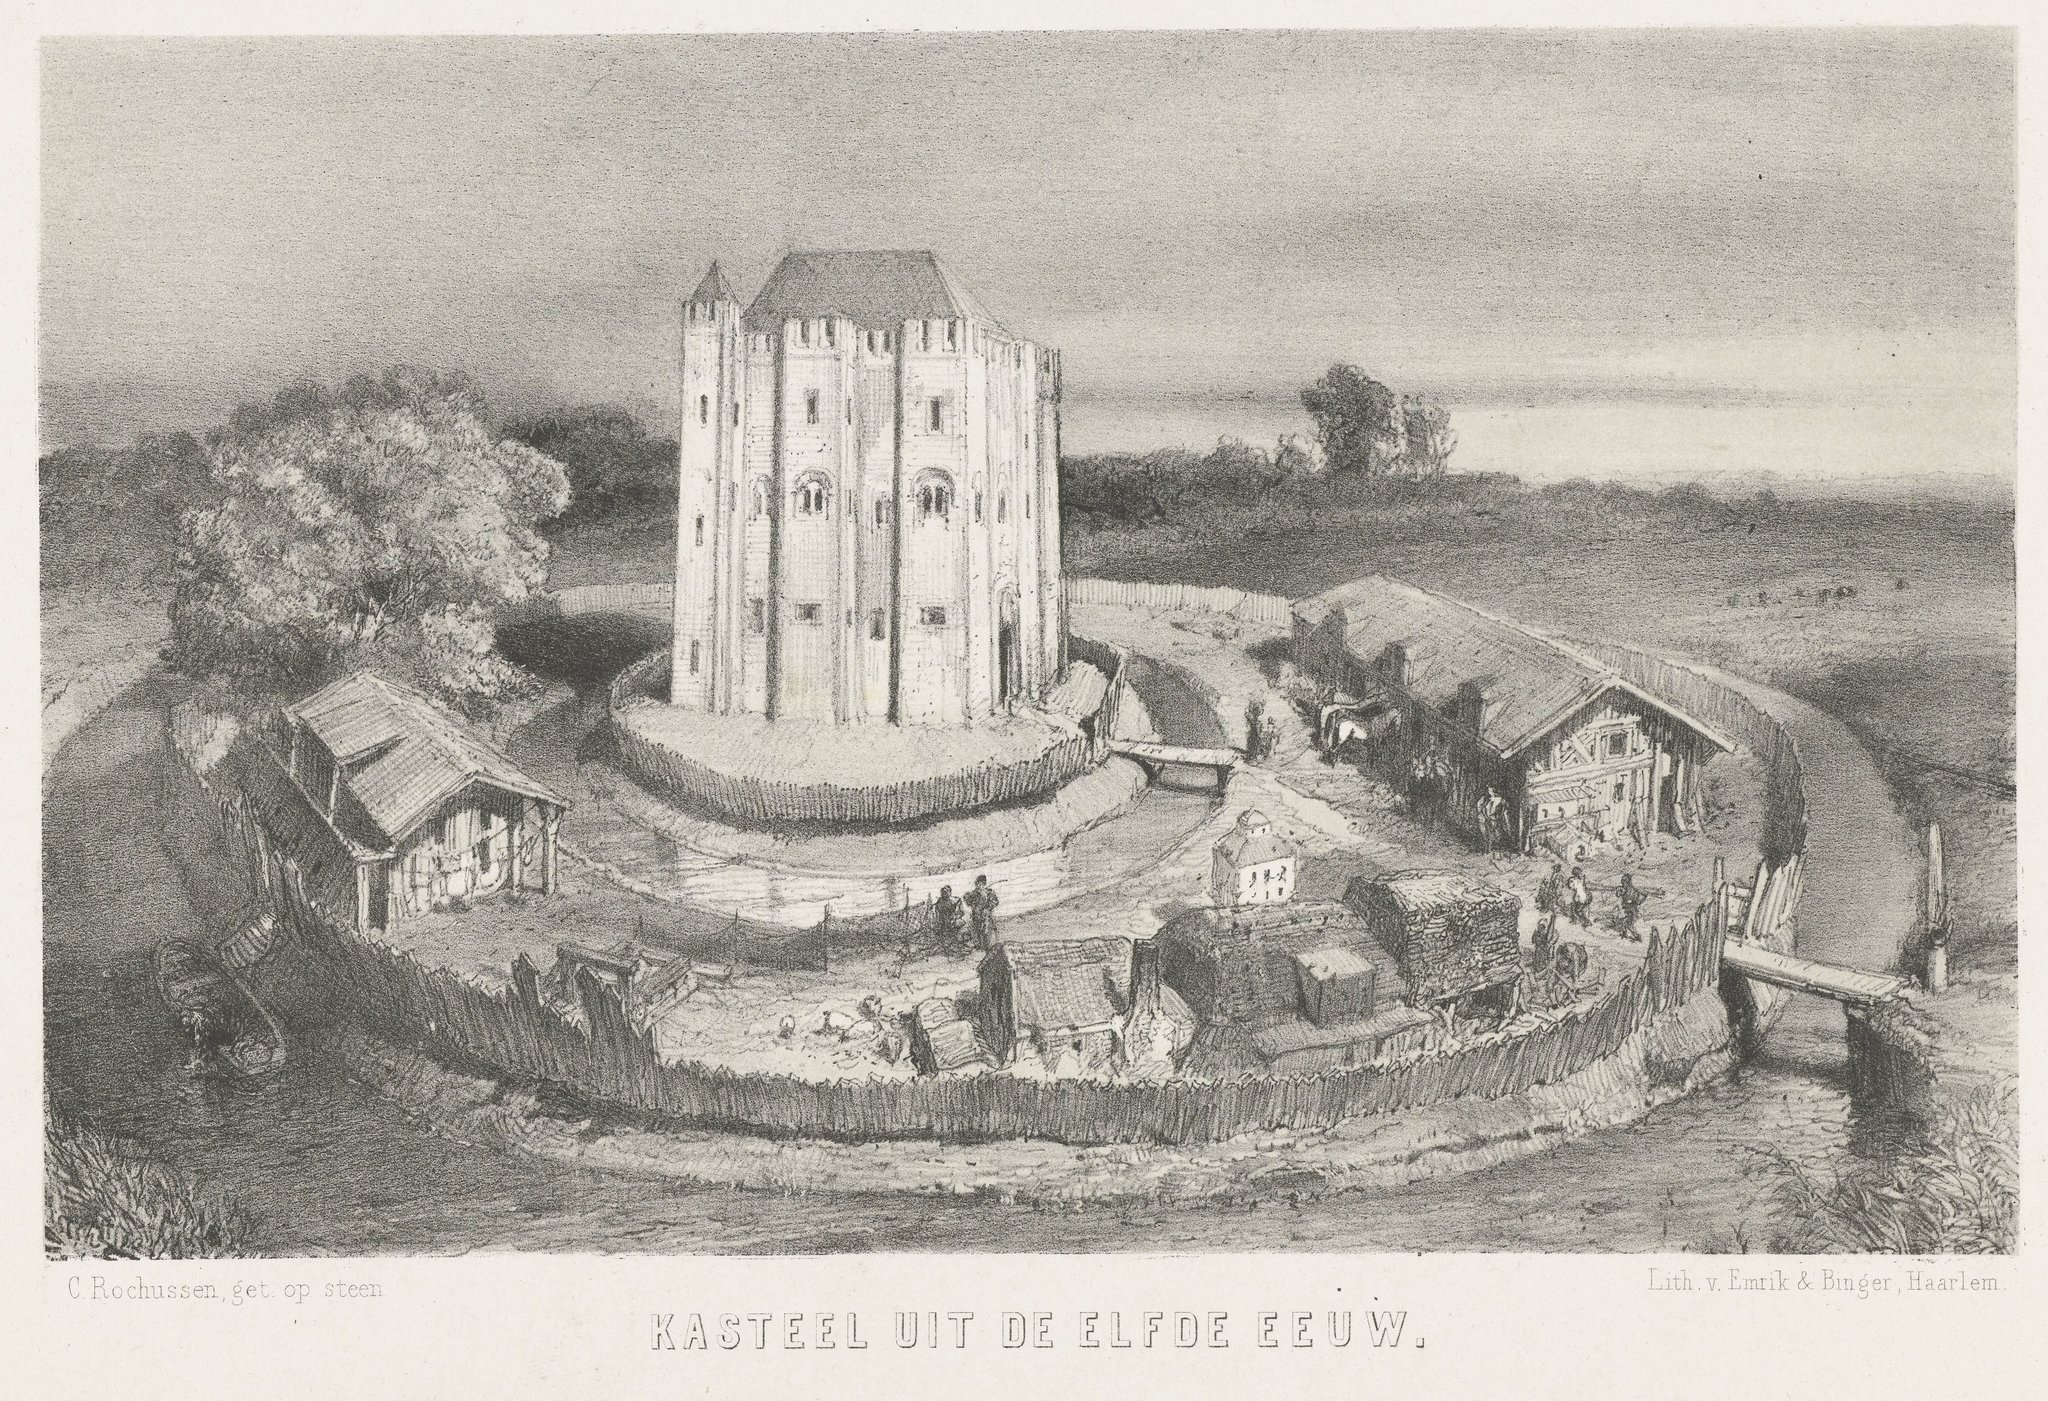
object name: history print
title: Kasteel uit de elfde eeuw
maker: charles rochussen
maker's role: draughtsman, painter, print maker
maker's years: 1814-1894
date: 1857-1864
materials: paper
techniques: lithograph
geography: netherlands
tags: castle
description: Illustratie uit: W.J. Hofdijk, Ons voorgeslacht in zijn dagelyksch leven geschilderd, Kruseman, Haarlem 1859-1864.